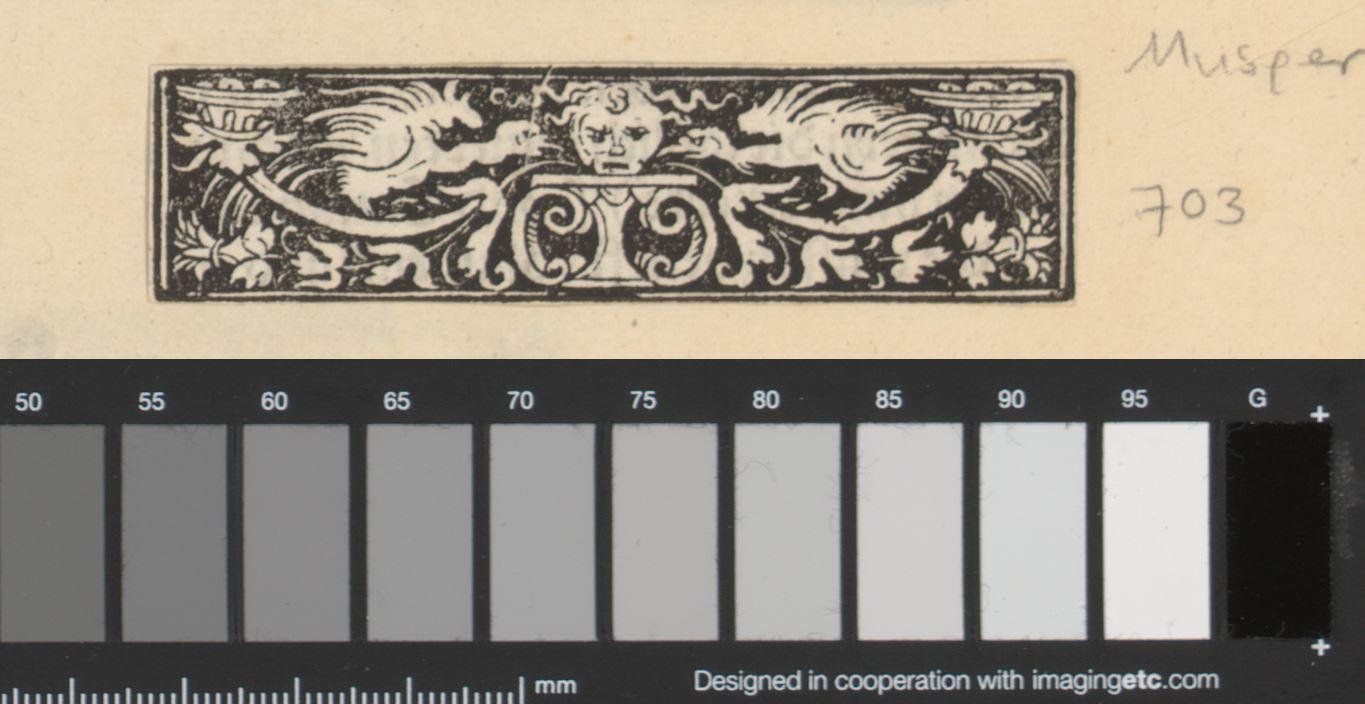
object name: book illustration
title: Hoofd op sokkel, twee vogels en ornamenten met bladmotief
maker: Anonymous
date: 1514-1532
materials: paper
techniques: letterpress printing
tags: fabulous animals ~ ornamental birds, foliated head ~ ornament, foliage, tendrils, branches ~ ornament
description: Deze prent is gebruikt als ornament in: Petrarca, Francesco. Von der Artzney bayder Glück, des guten und widerwertigen: unnd weß sich ain yeder inn Gelück und Unglück halten sol (...). Augsburg: Heinrich Steiner, 1532. Deze uitgave is ook bekend onder de titel 'Trostspiegel in Glück und Unglück'.